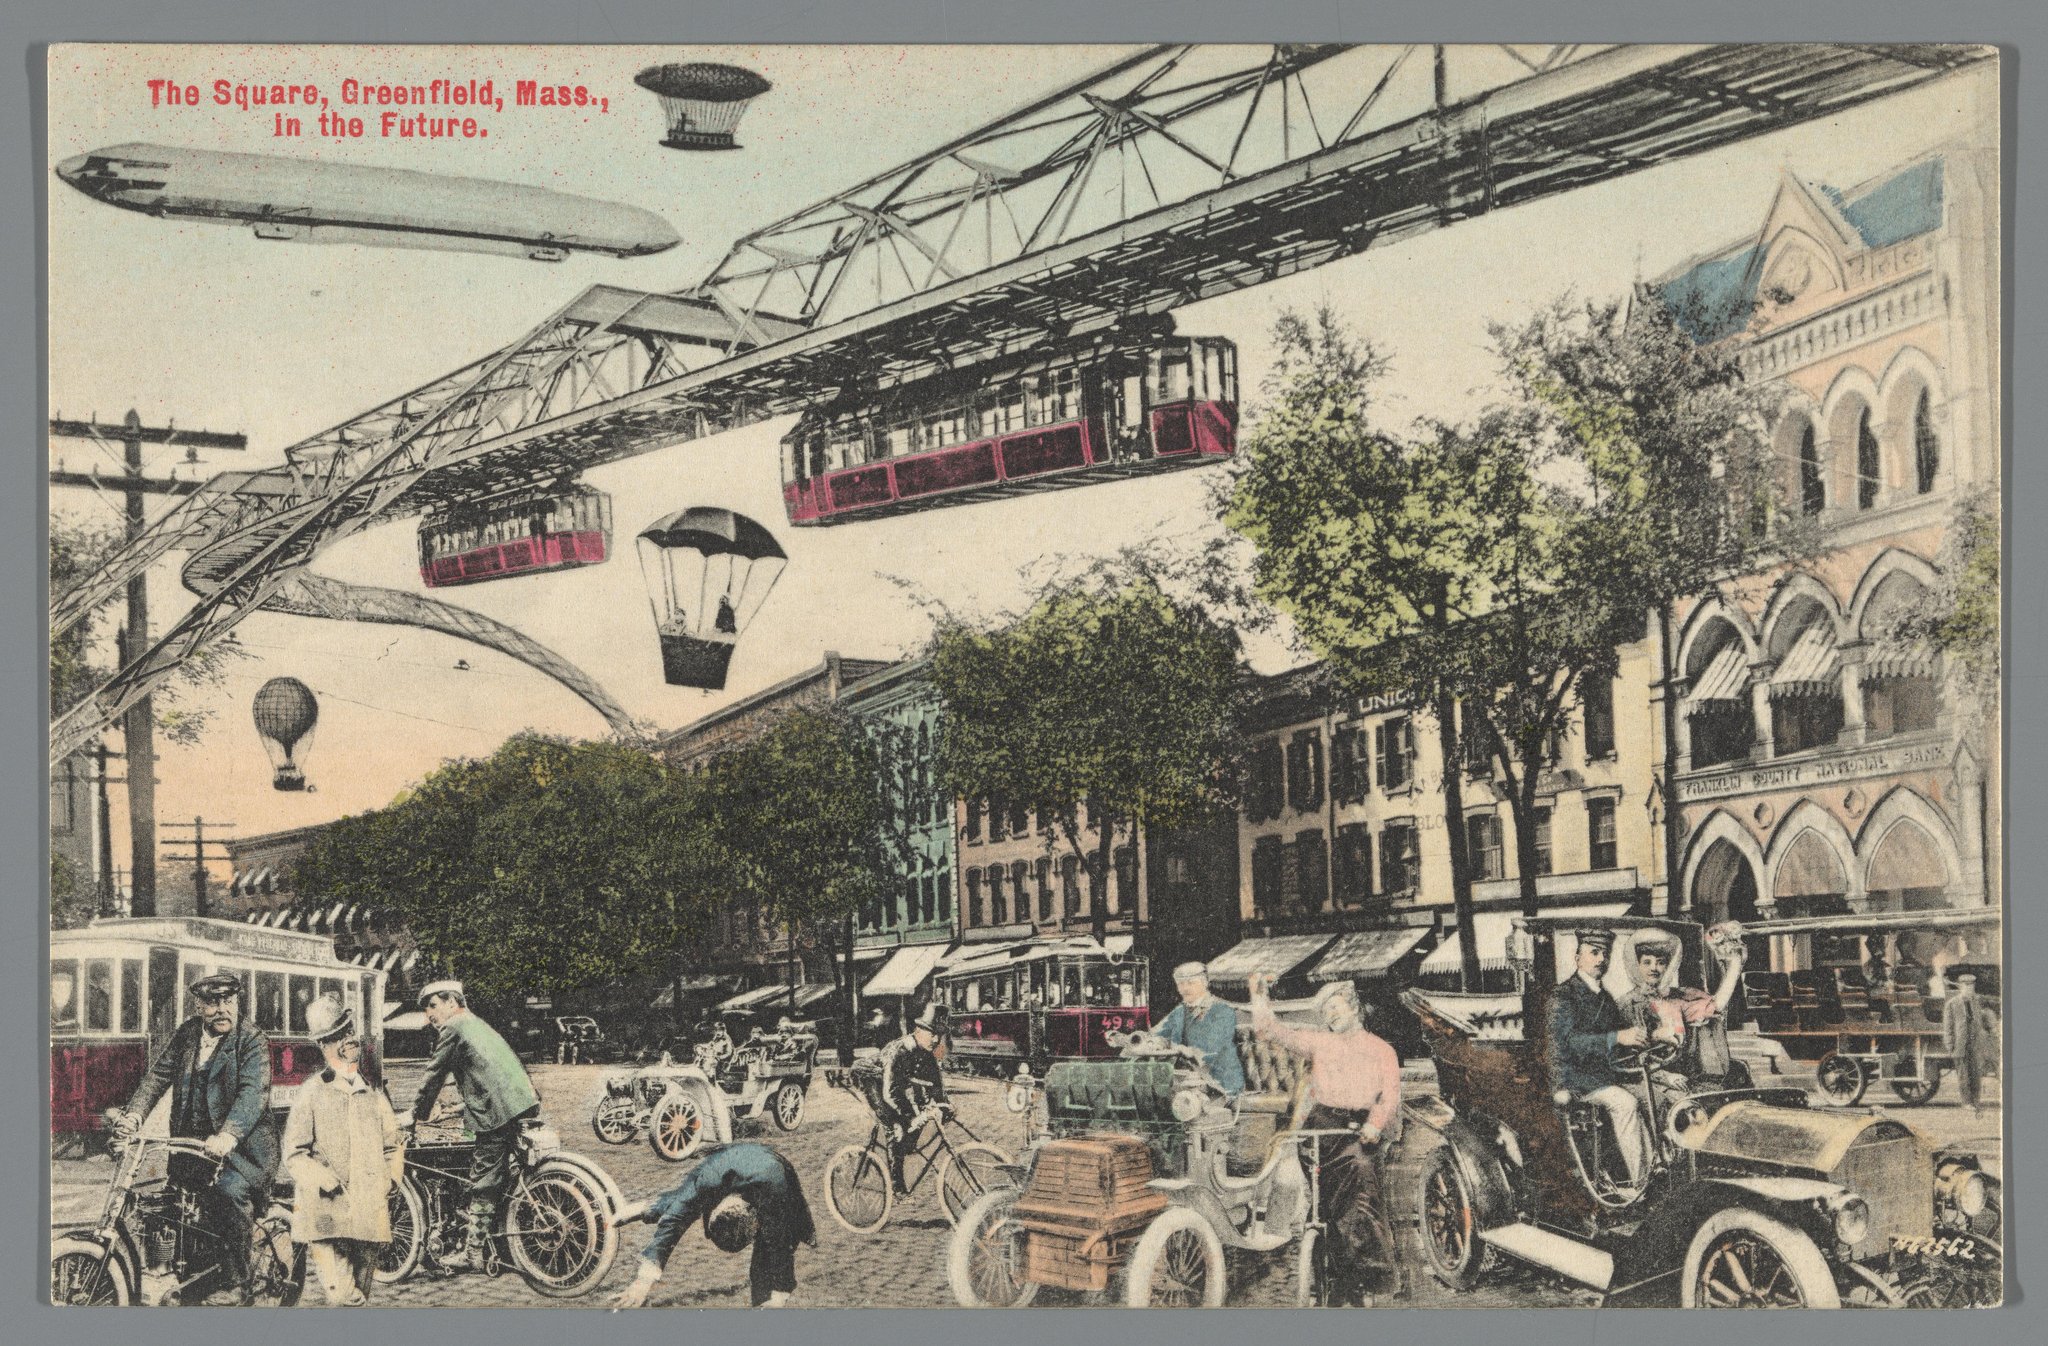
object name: ansichtkaart, prentbriefkaart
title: City of the Future (Greenfield, MA)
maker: Anonymous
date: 1910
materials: cardboard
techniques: collage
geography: austria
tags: greenfield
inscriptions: inscription: ‘Made in Austria. / POST CARD / MESSAGE / ADDRESS / Place / Stamp here / DOMESTIC / 1 c / FOREIGN / 2 c’, inscription: ‘The Square, Greenfield, Mass., / in the Future.’